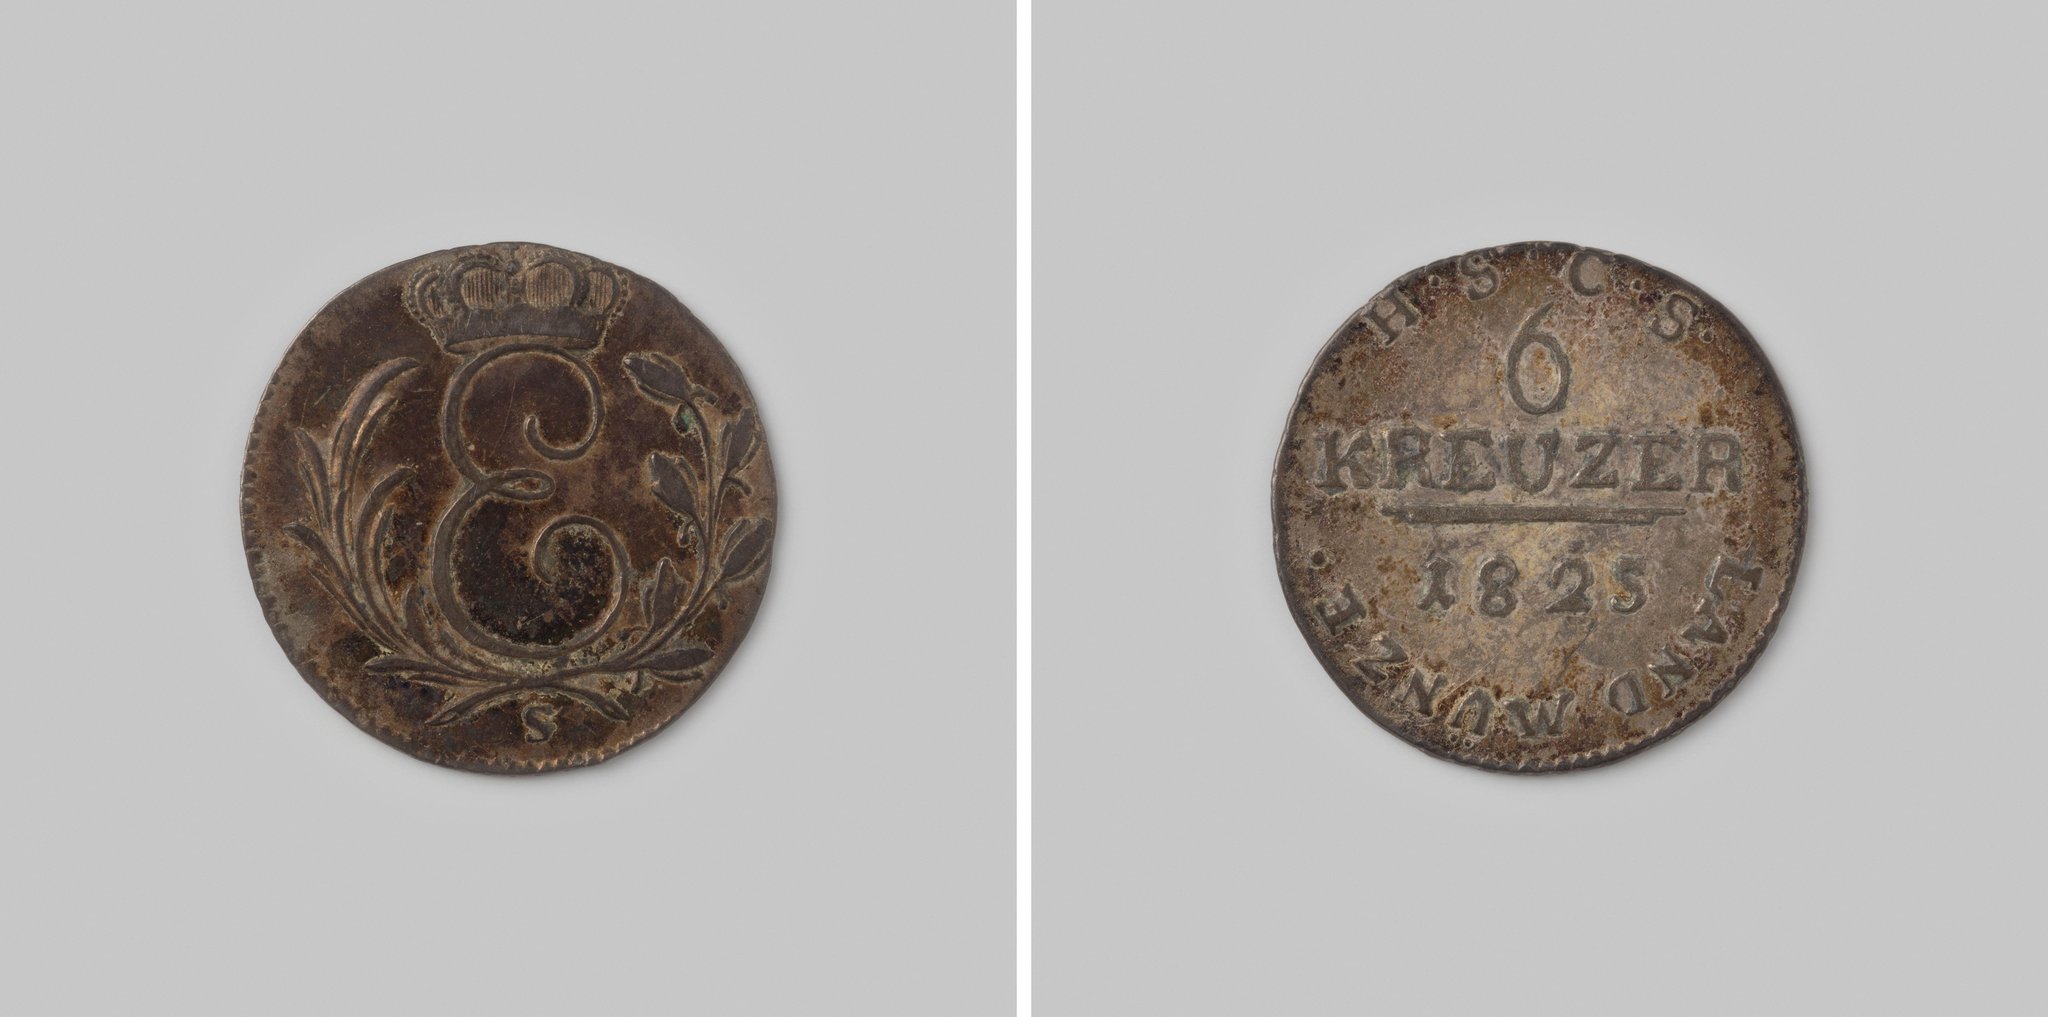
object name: coin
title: Saksen-Coburg-Saalfeld, Ernst I, 6 Kreuzer, 1825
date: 1825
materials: silver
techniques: striking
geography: saalfeld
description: Zilveren munt. Voorzijde: binnen twee samengebonden takken, waaronder de letter S, gekroond monogram van de hertog. Keerzijde: waarde-aanduiding in twee regels, waaronder jaartal.